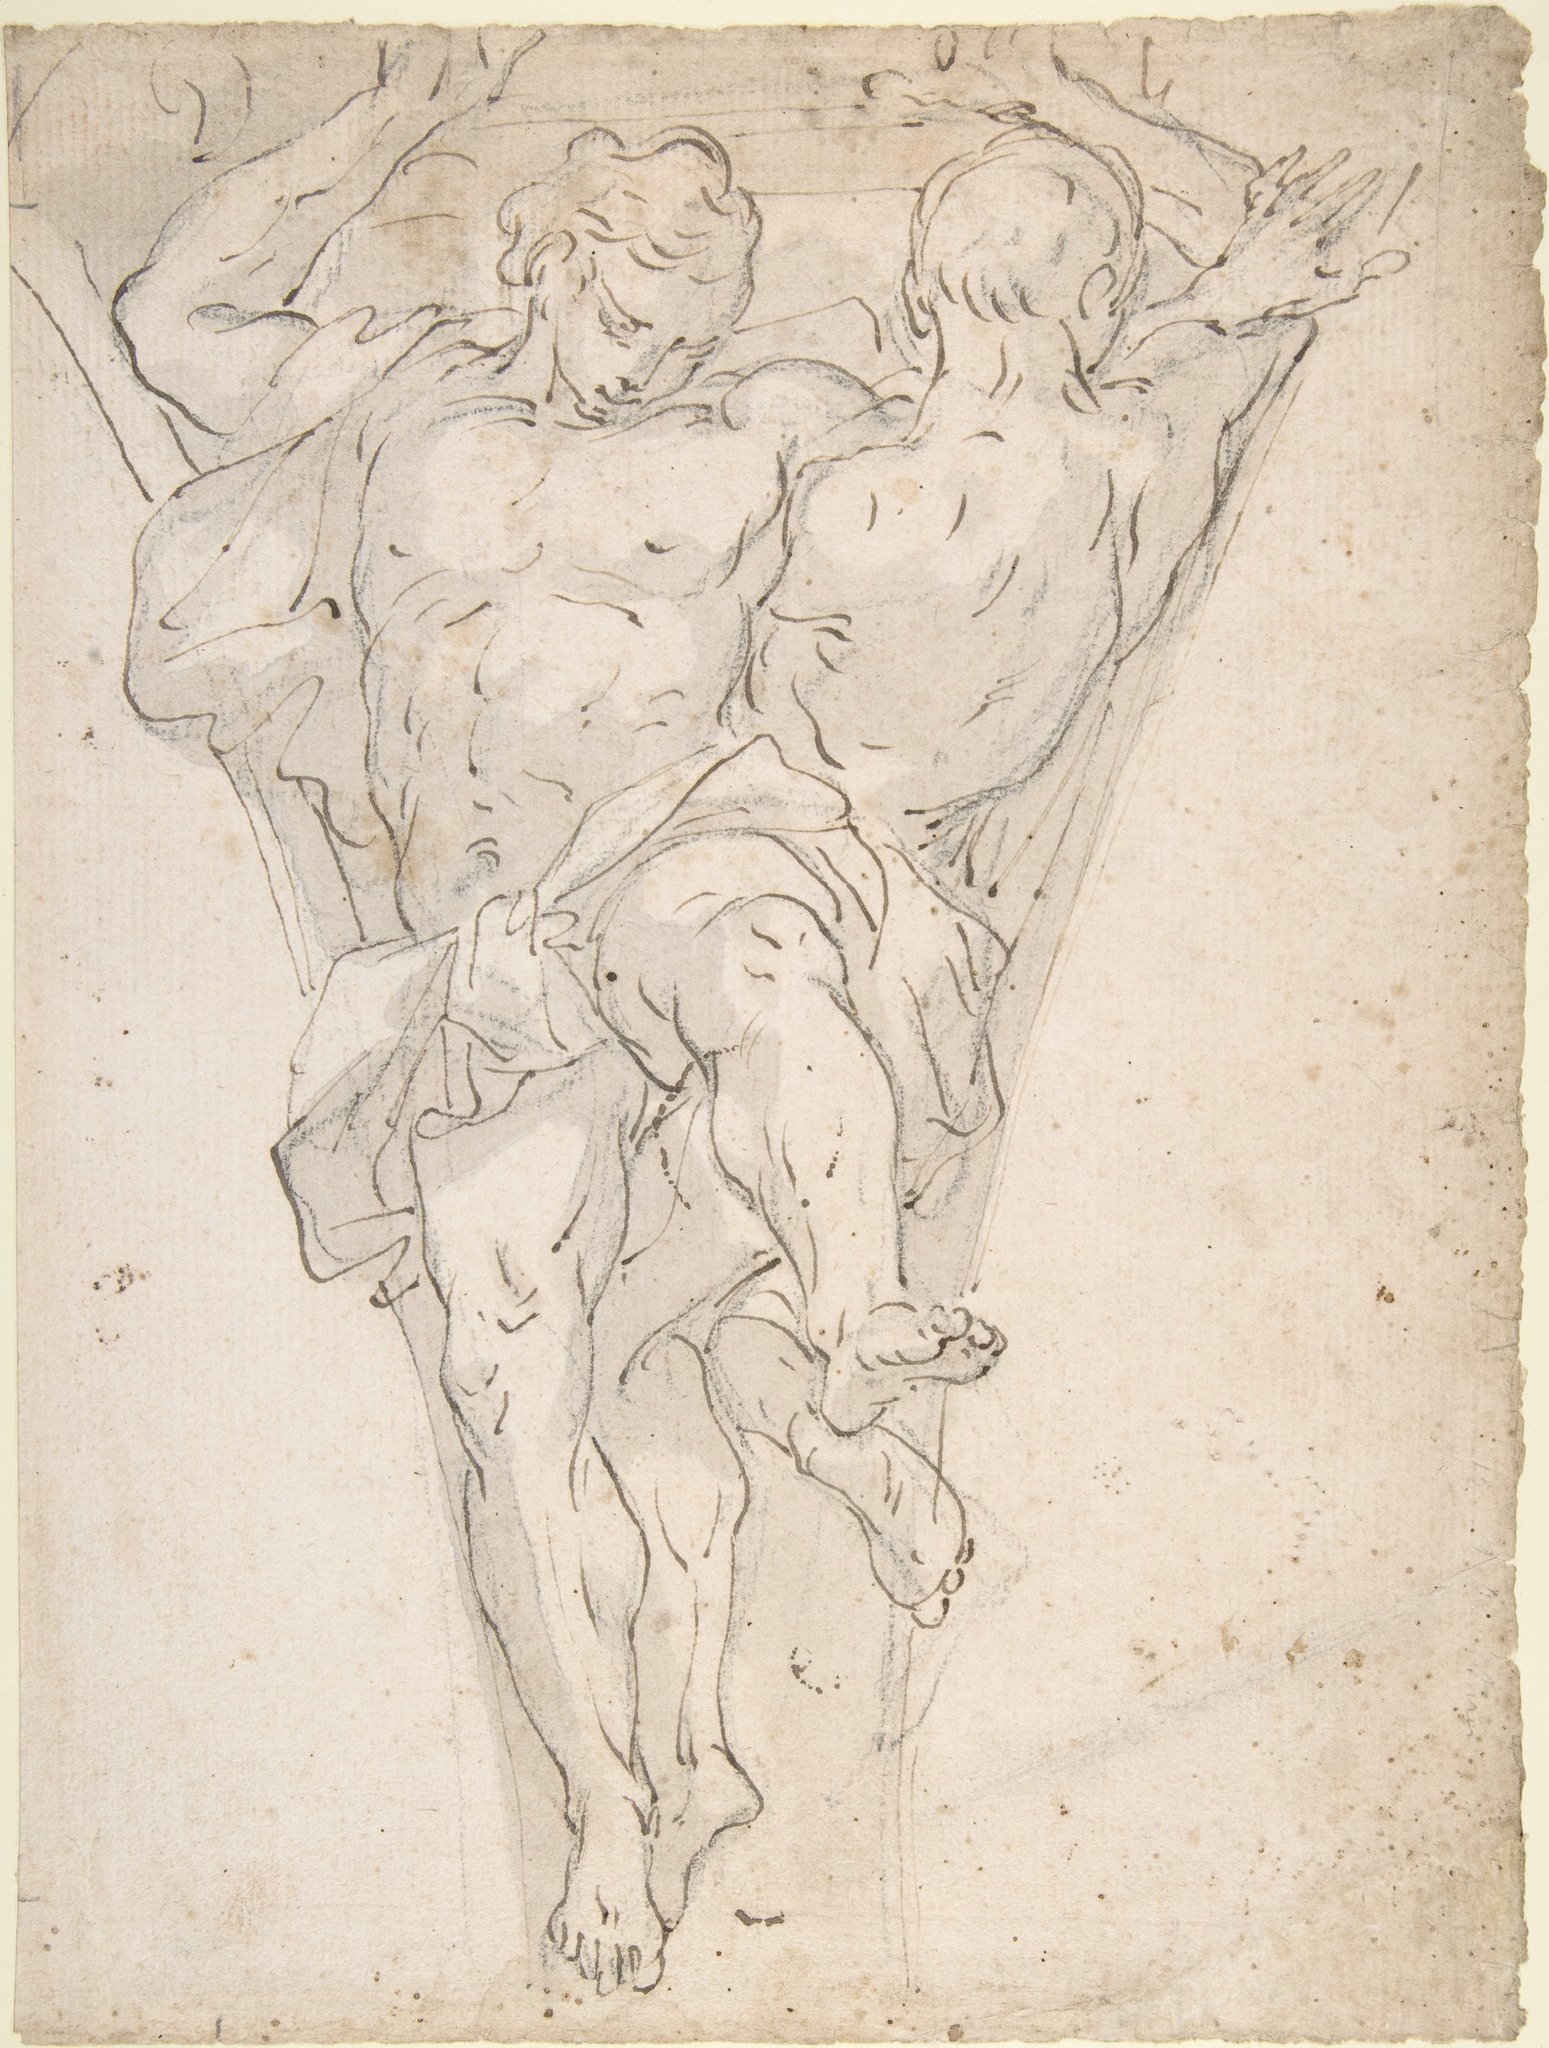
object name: drawing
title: Two Partially Draped Male Figures in a Pendentive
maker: giovanni battista carlone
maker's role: artist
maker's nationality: italian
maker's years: 1603-1684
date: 1603-1684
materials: chalk, ink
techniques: brush, pen, wash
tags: men